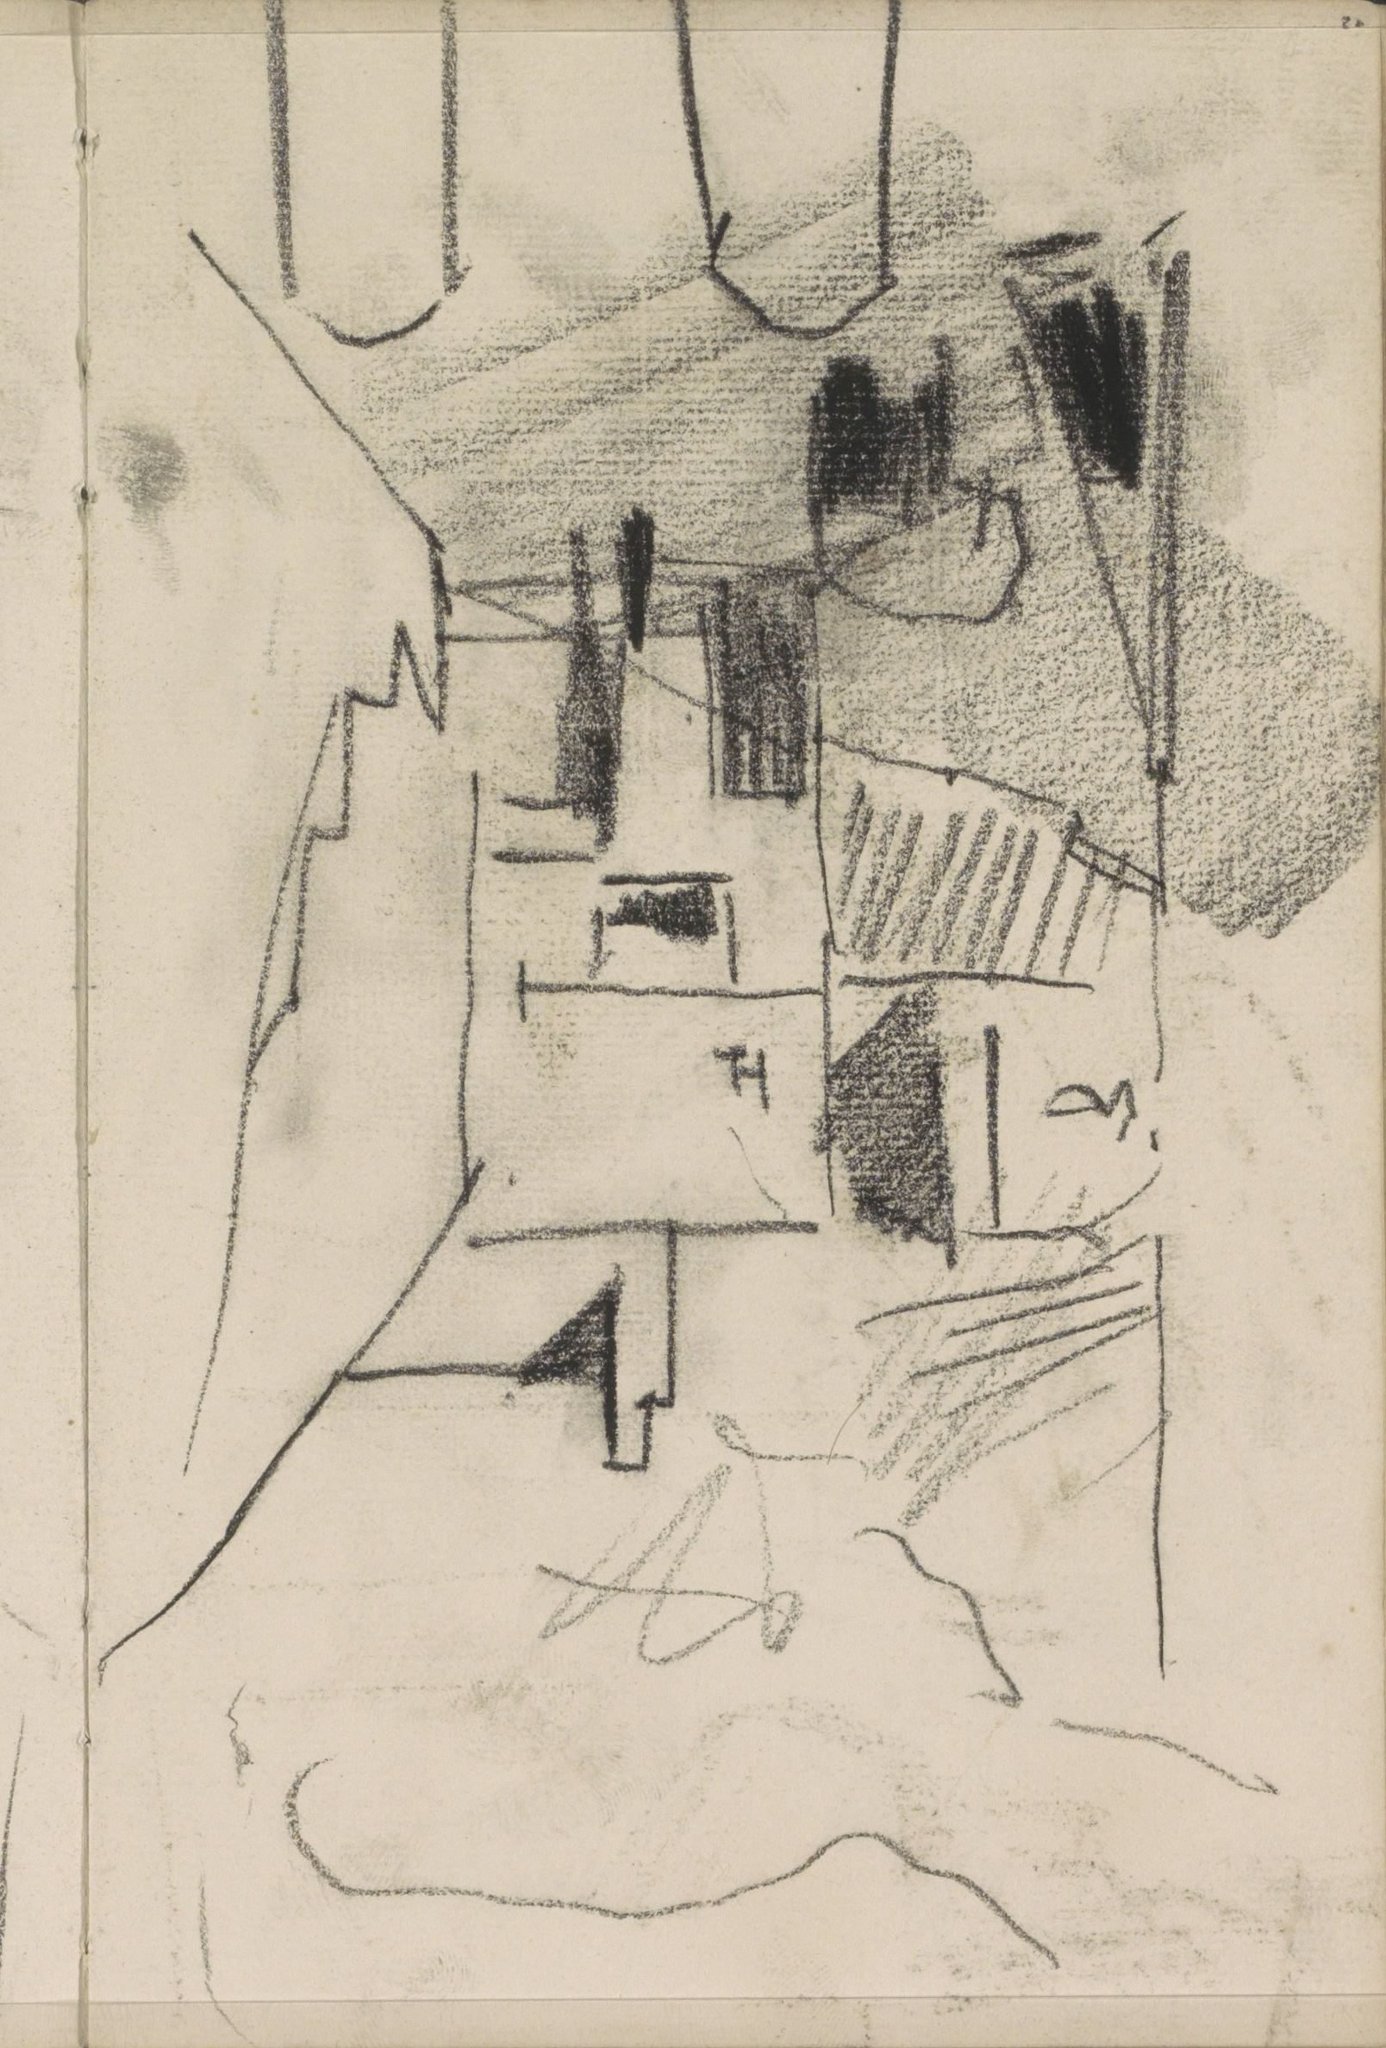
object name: sketchbook leaf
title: Bukkende figuur in een steeg of op een binnenplaats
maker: george hendrik breitner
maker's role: draughtsman, painter, print maker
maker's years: 1857-1923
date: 1883-1885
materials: chalk, paper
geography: the hague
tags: bending figure, lane, alley (+ city(-scape) with figures, staffage)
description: Pagina 20 uit een schetsboek met 18 bladen.